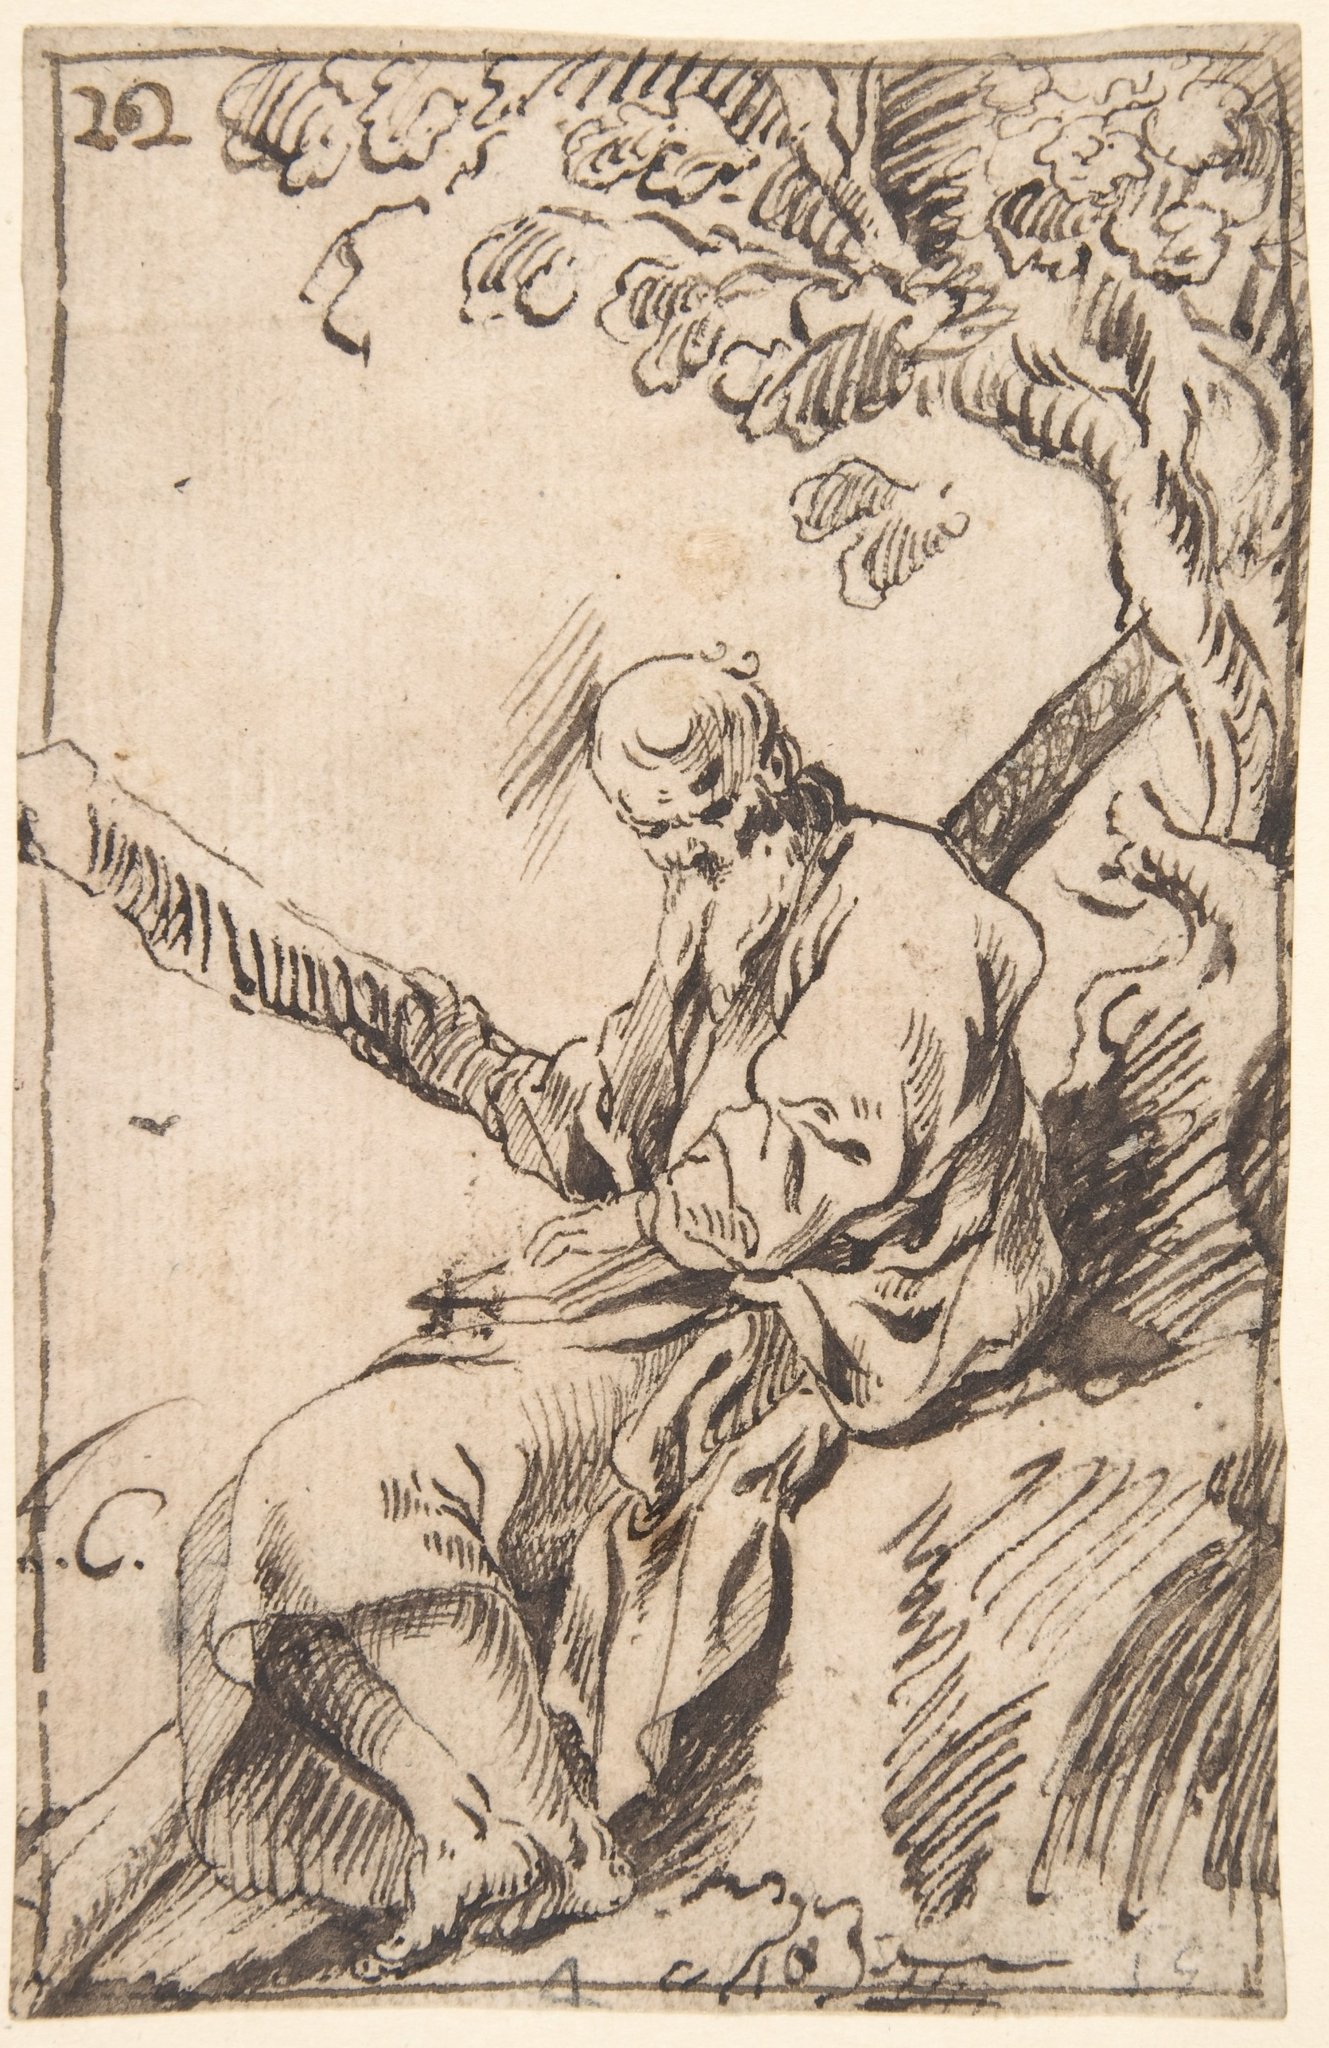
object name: drawing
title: Figure of St. Andrew seated in a Landscape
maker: antonio del castillo y saavedra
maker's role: artist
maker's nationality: spanish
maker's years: 1616-1668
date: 1616-1668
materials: chalk, ink, paper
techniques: pen, drawing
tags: men,landscapes,saints